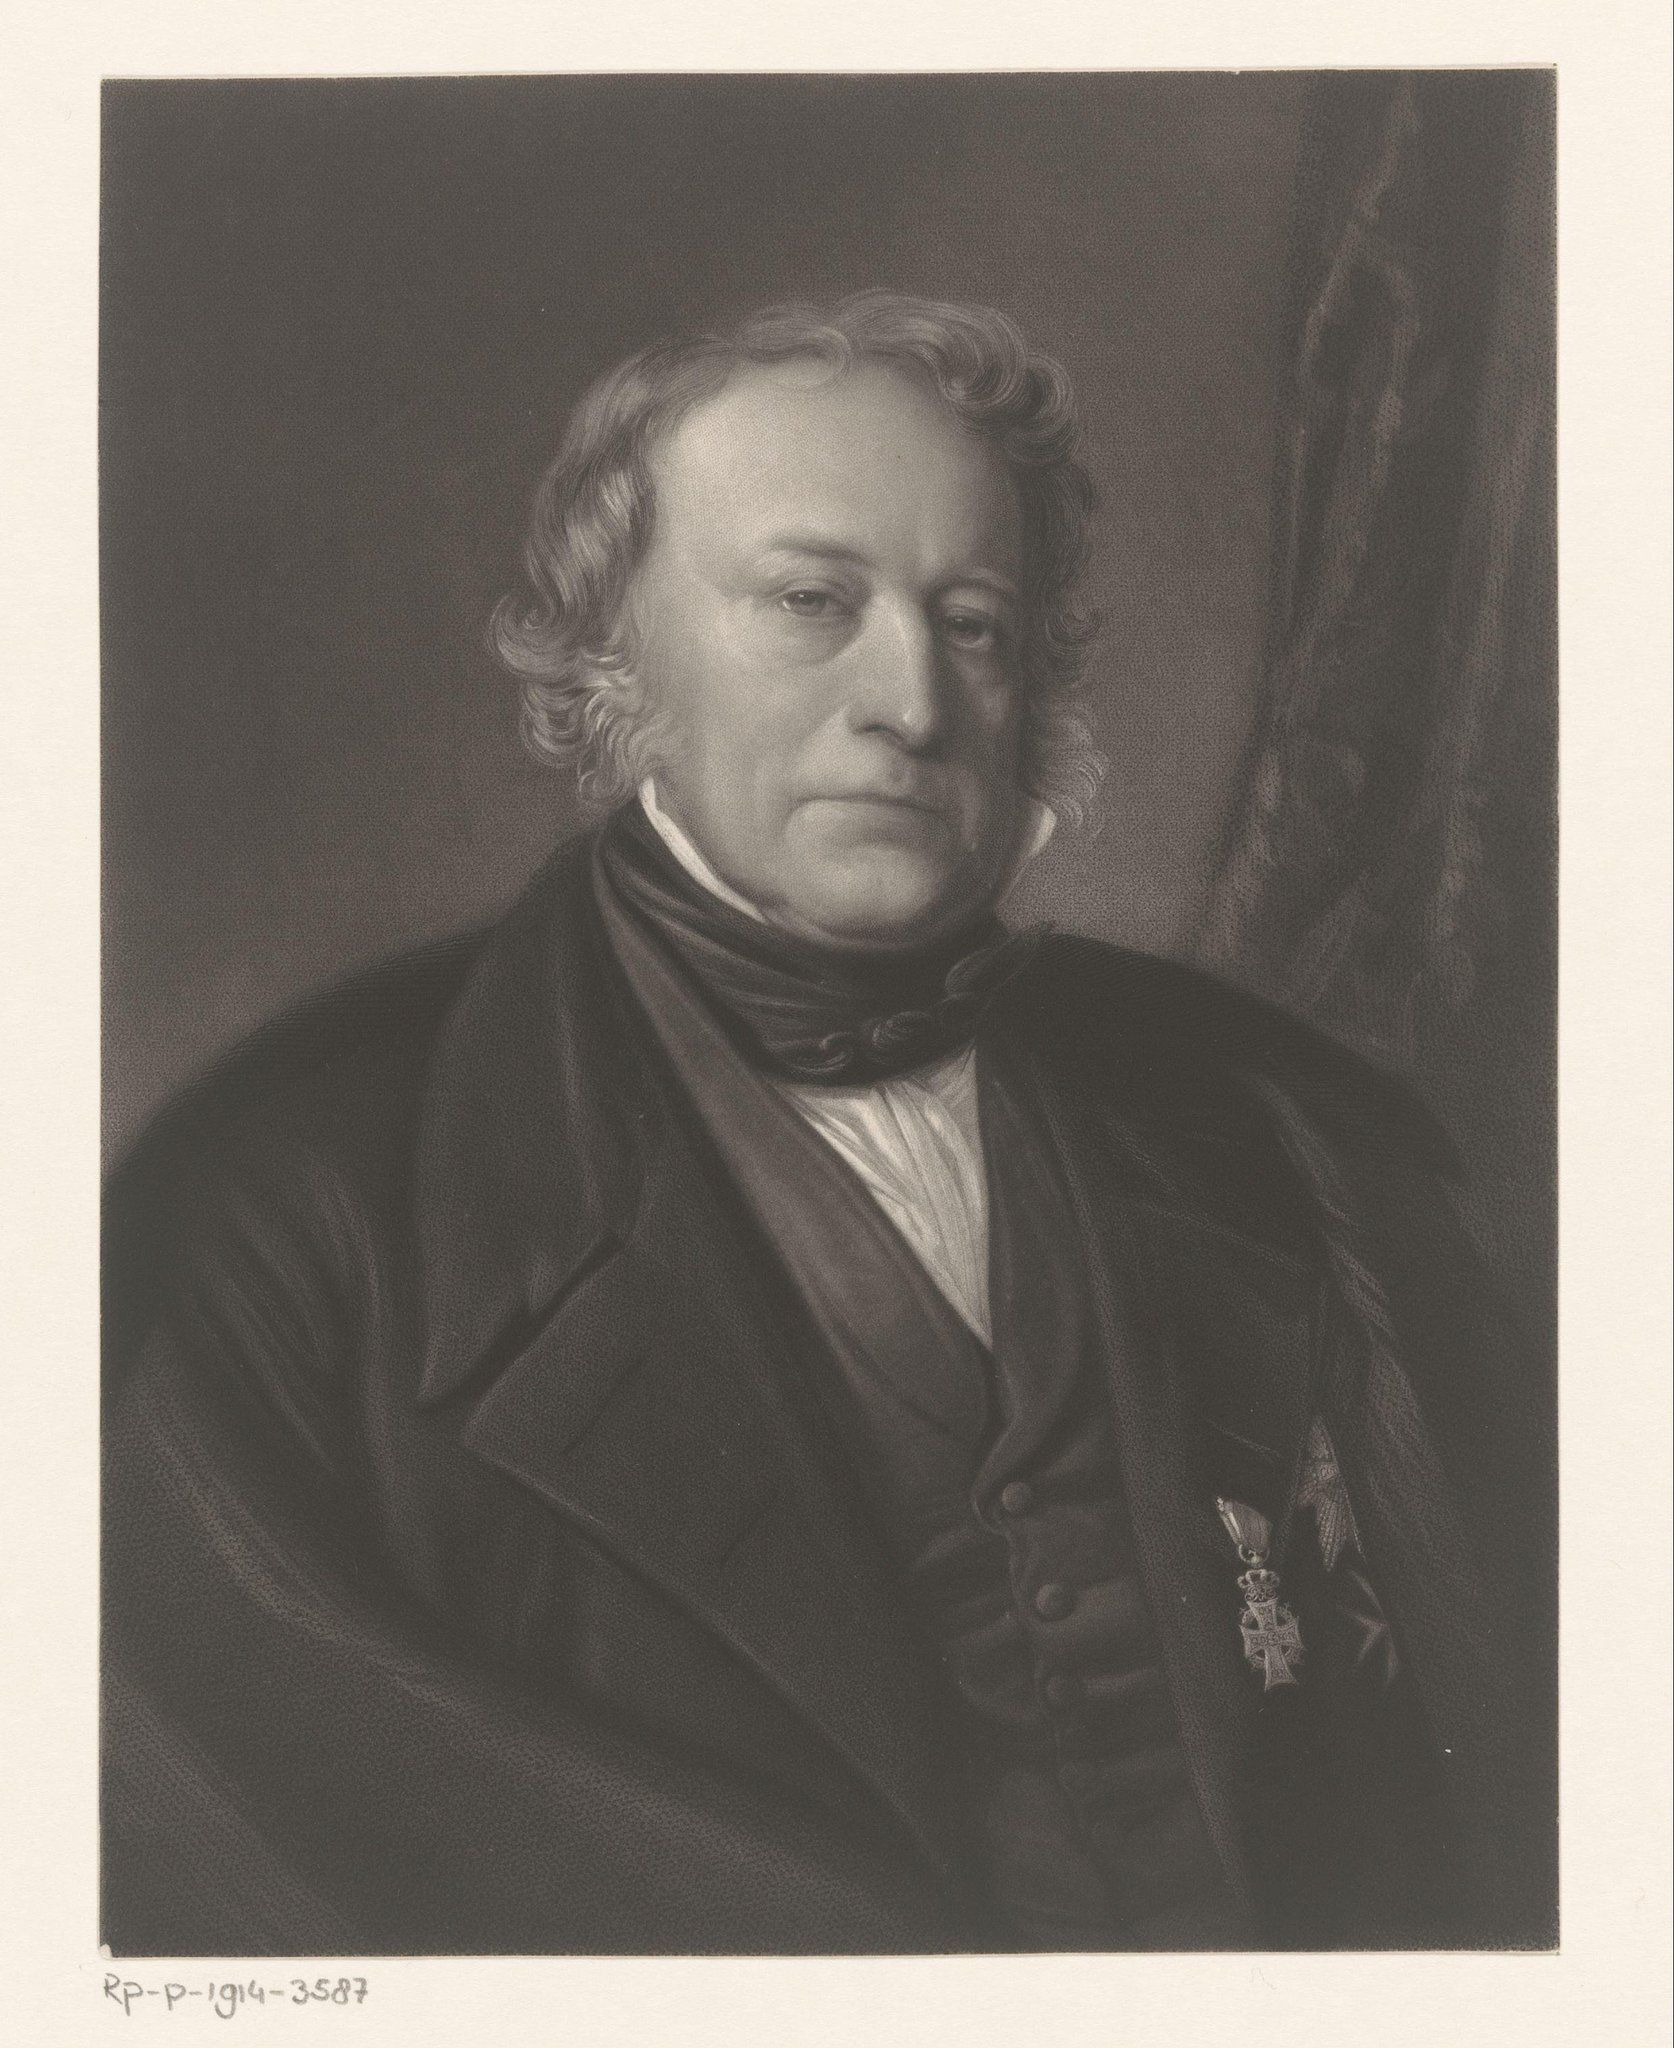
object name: print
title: Portret van een onbekende man, mogelijk genaamd Jacobs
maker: hermann sagert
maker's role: print maker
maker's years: 1822-1889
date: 1832-1889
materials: paper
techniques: etching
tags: knighthood order, historical persons, medals and other marks of military honour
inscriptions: collector's mark: Lugt 2228